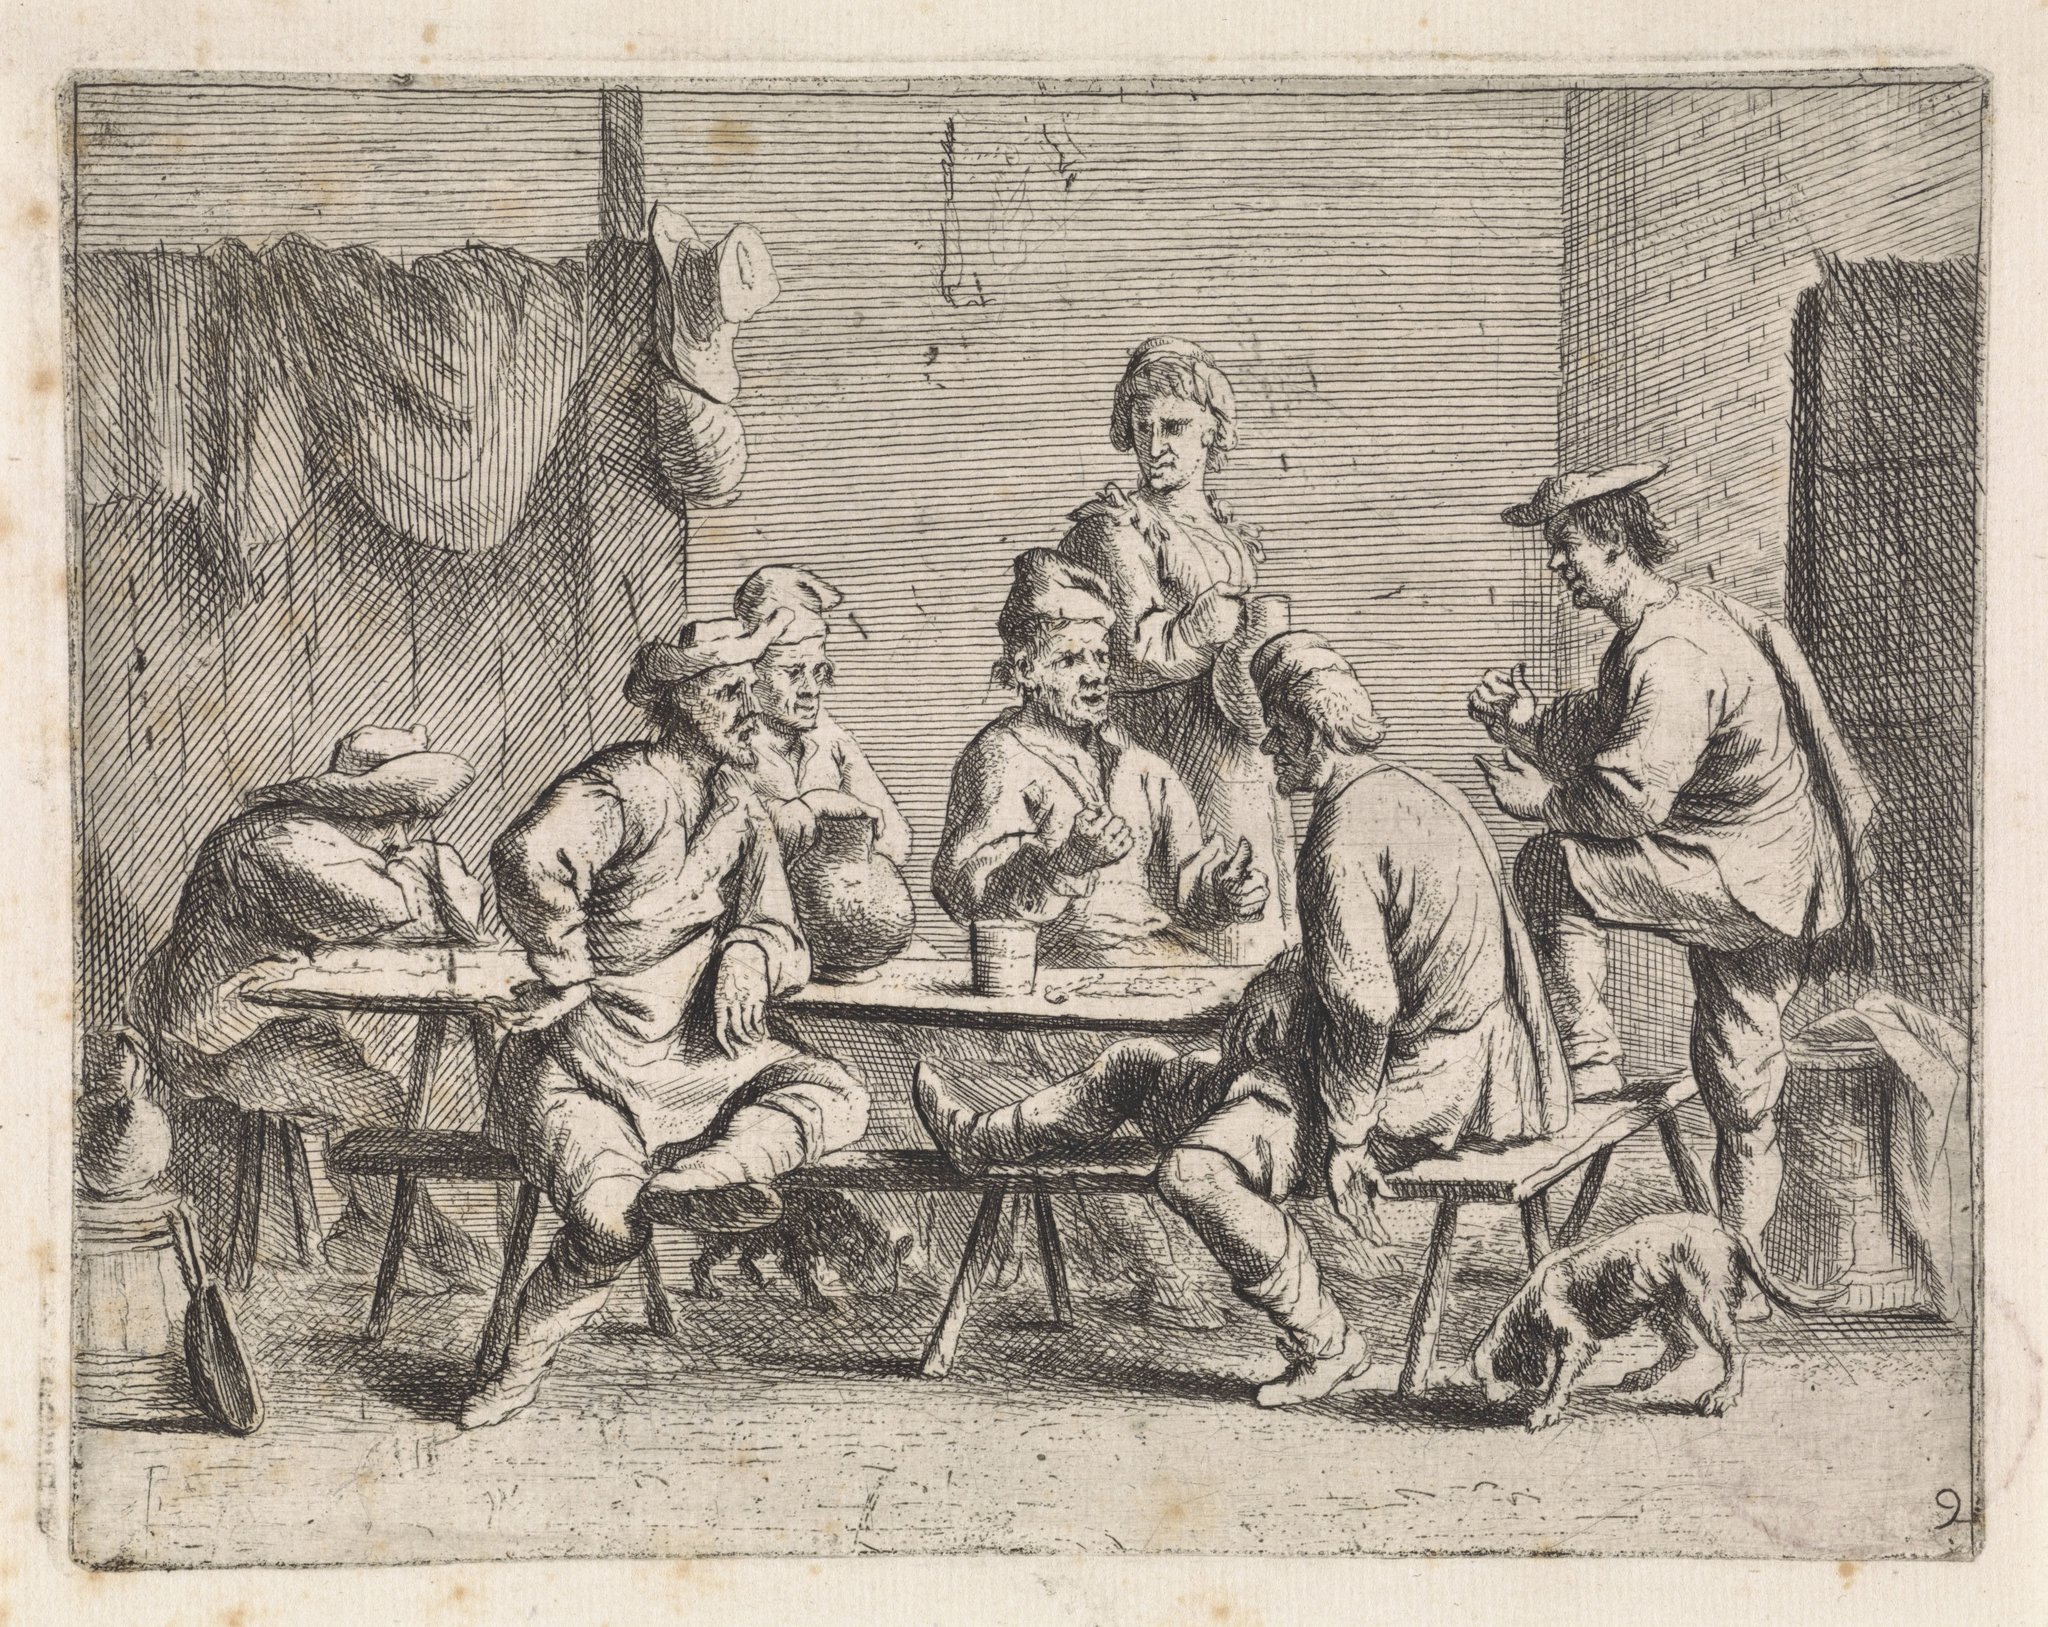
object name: print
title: Genretaferelen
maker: Anonymous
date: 1630-1698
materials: paper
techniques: engraving, etching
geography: italy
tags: inn, coffee-house, public house, etc., dog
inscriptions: collector's mark: Lugt 240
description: Interieur van een herberg met boeren die in gesprek zijn. Achter de tafel staat een de herbergierster met een kan in de hand. Rechts op de voorgrond een hond.